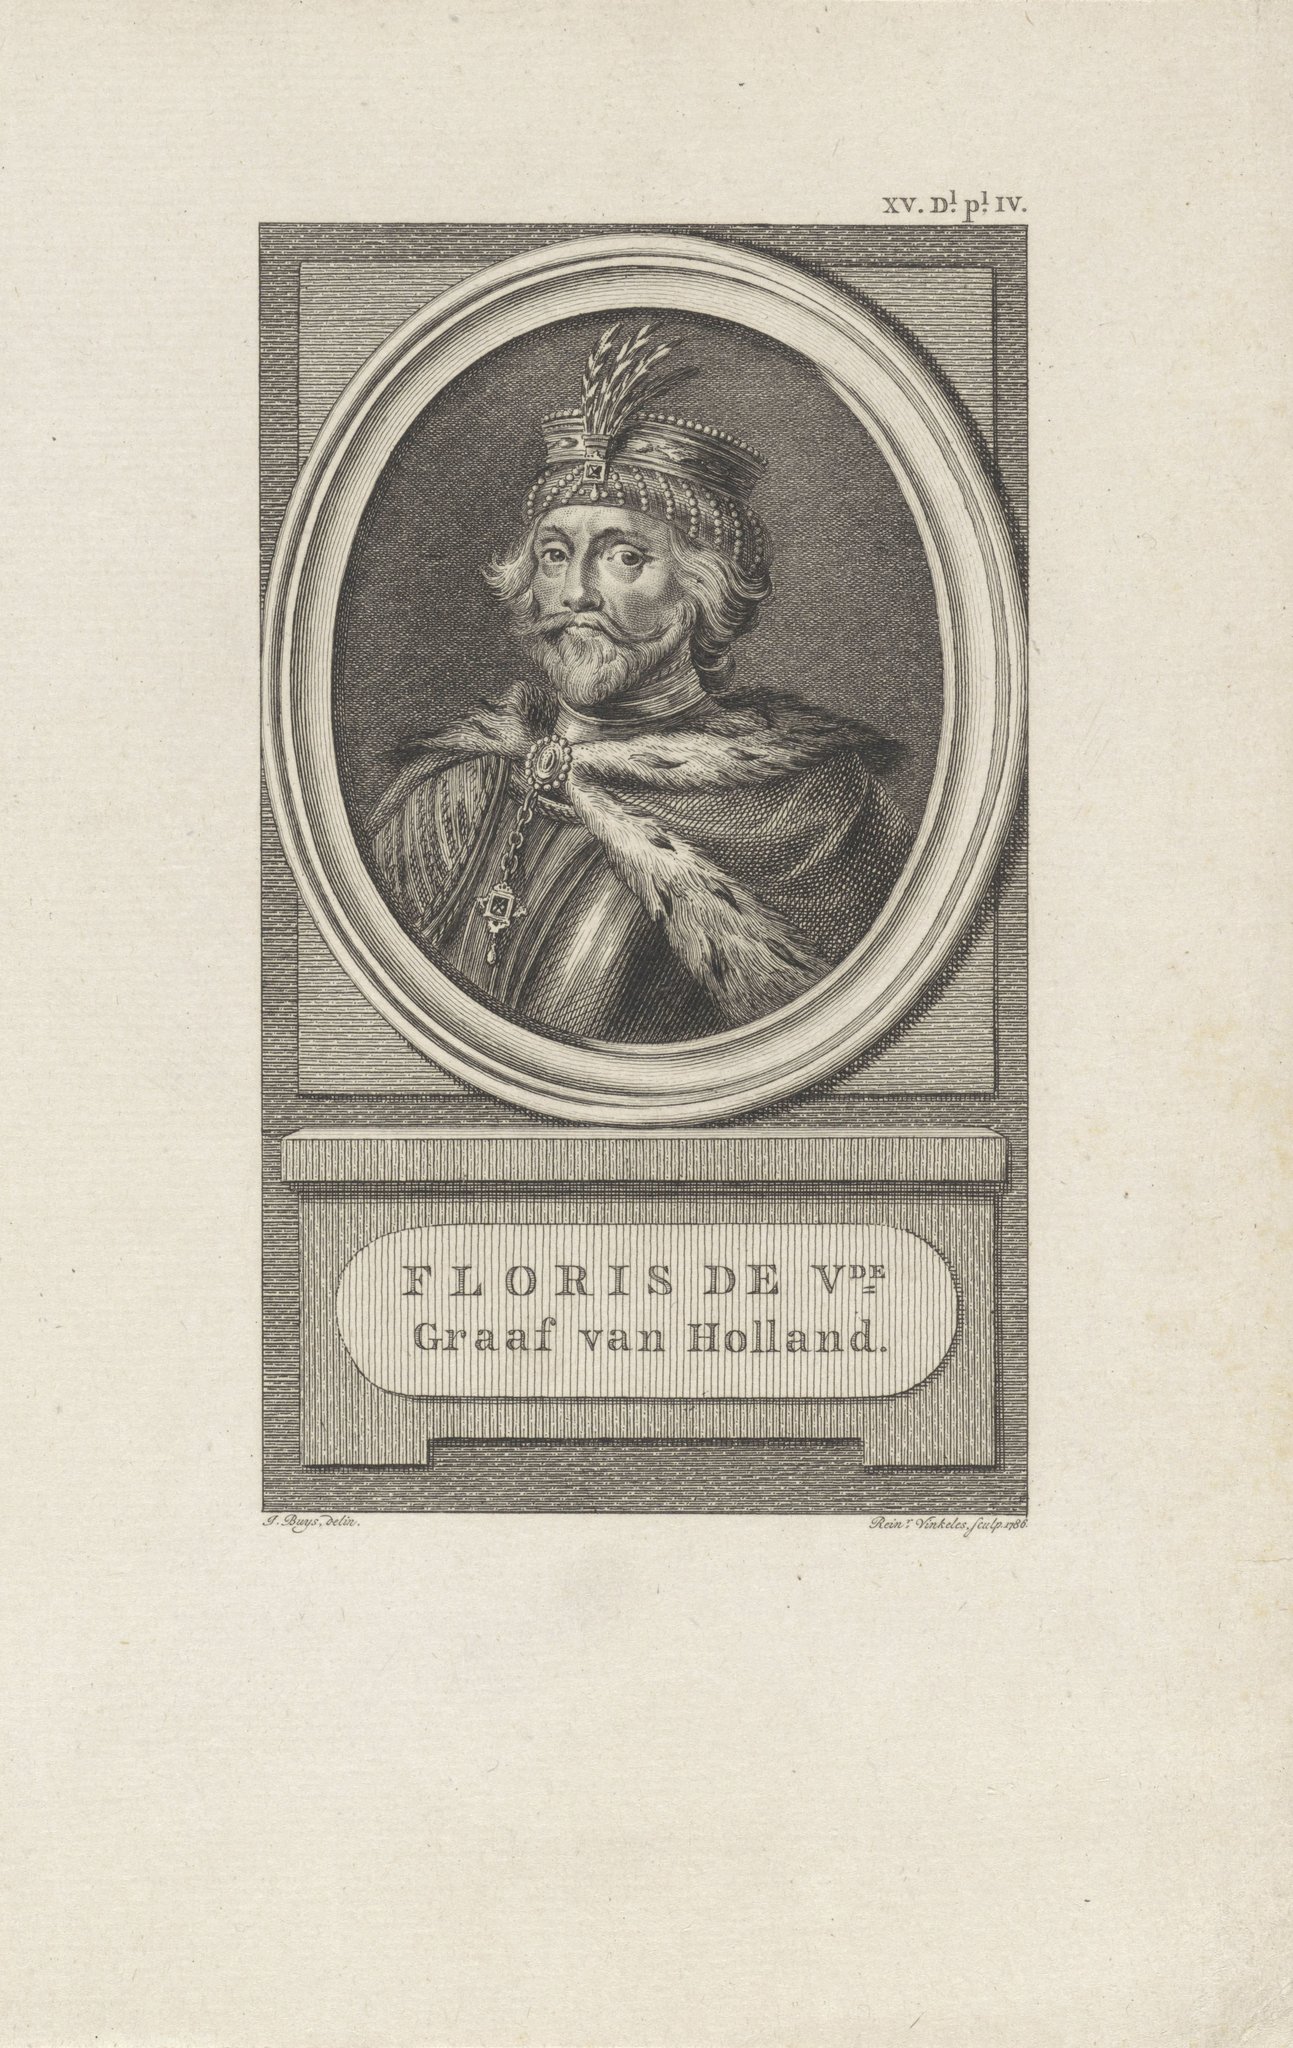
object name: print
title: Portret van Floris V, graaf van Holland en Zeeland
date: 1786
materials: paper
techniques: engraving, etching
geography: amsterdam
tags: floris v (graaf van holland en zeeland)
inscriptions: collector's mark: Lugt 2228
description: Prent gebruikt als boekillustratie in: Kok, Jacobus. Vaderlandsch woordenboek : met kaarten, plaaten en pourtraitten. Amsterdam: Johannes Allart, 1785-1796. Deel XV.